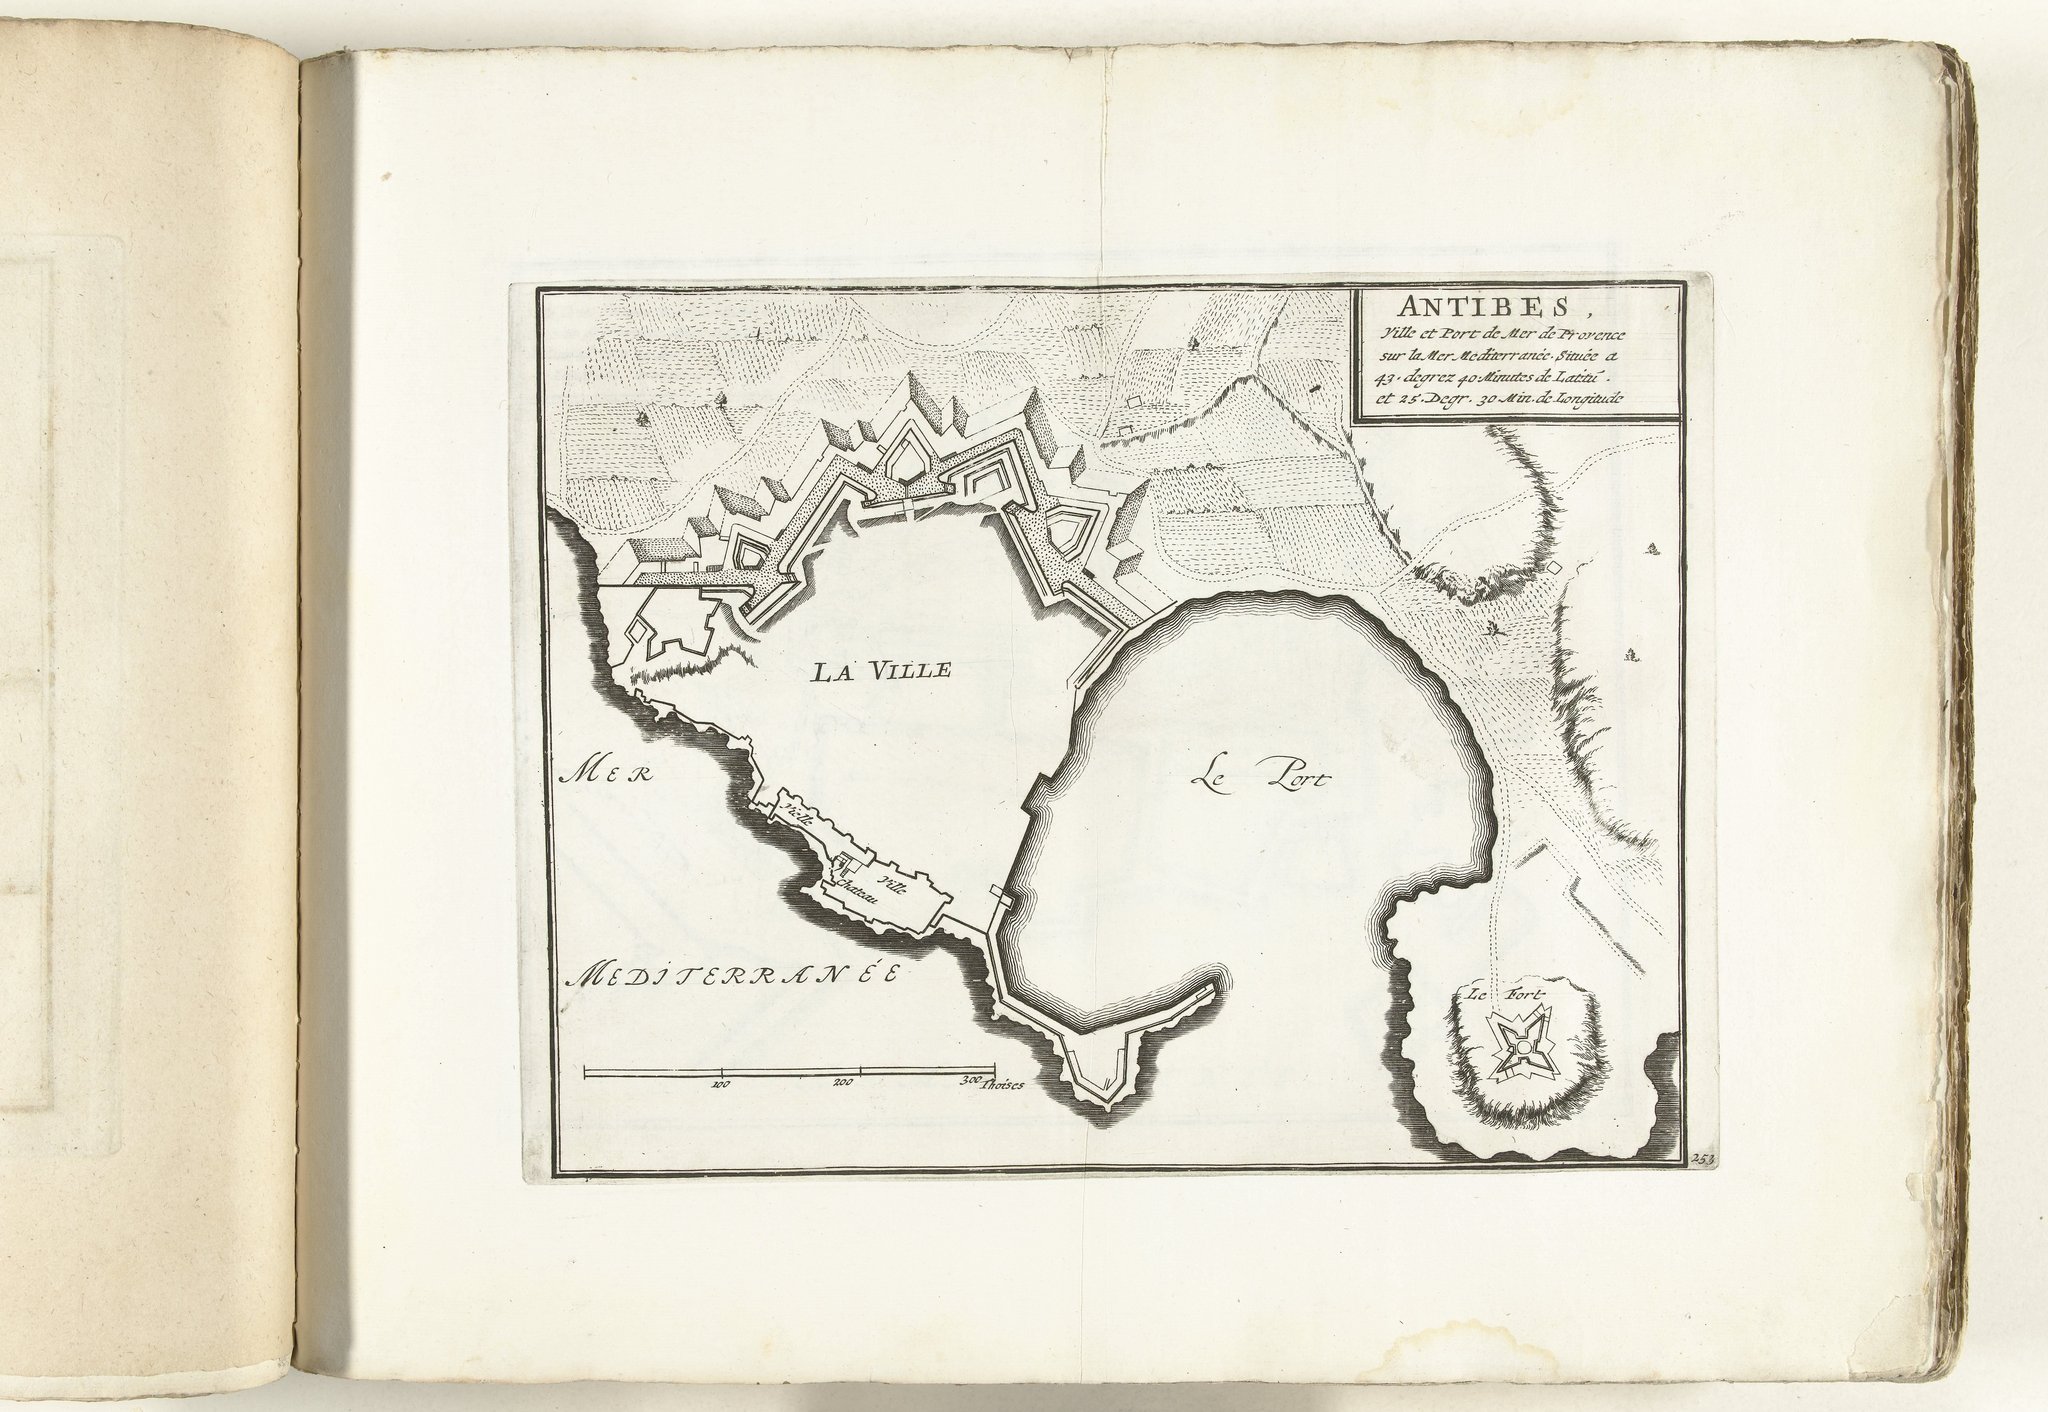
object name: map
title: Plattegrond van Antibes, ca. 1702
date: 1702-1703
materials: paper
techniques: engraving, etching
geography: northern netherlands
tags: fortress, maps of cities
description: Plattegrond van de versterkingen om de Franse stad Antibes. Plaat nr. 253 in het prentwerk bestaande in totaal uit 276 genummerde platen van vermaarde sterke steden en vestingen in het kader van de Spaanse Successieoorlog. Voor het merendeel zijn deze platen gekopieerd naar de anonieme Franse platen: in Les forces de l'Europe en in: Le theatre de la guerre, dans les Pays-Bas, beide oorspronkelijk uitgegeven door Nicolas de Fer te Parijs (1693-1697) in het kader van de Negenjarige Oorlog. Titel en opschriften in de plaat in het Frans.